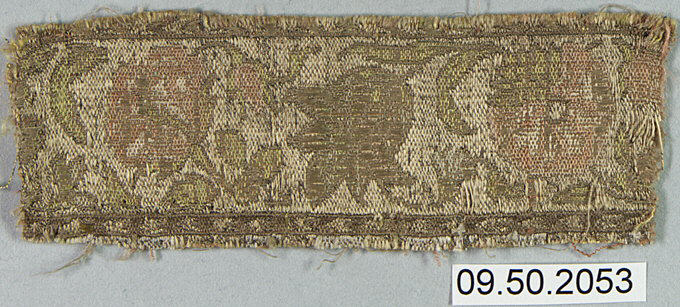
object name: band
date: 1601-1800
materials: linen, metal thread, silk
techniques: brocade, weave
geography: iran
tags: flowers